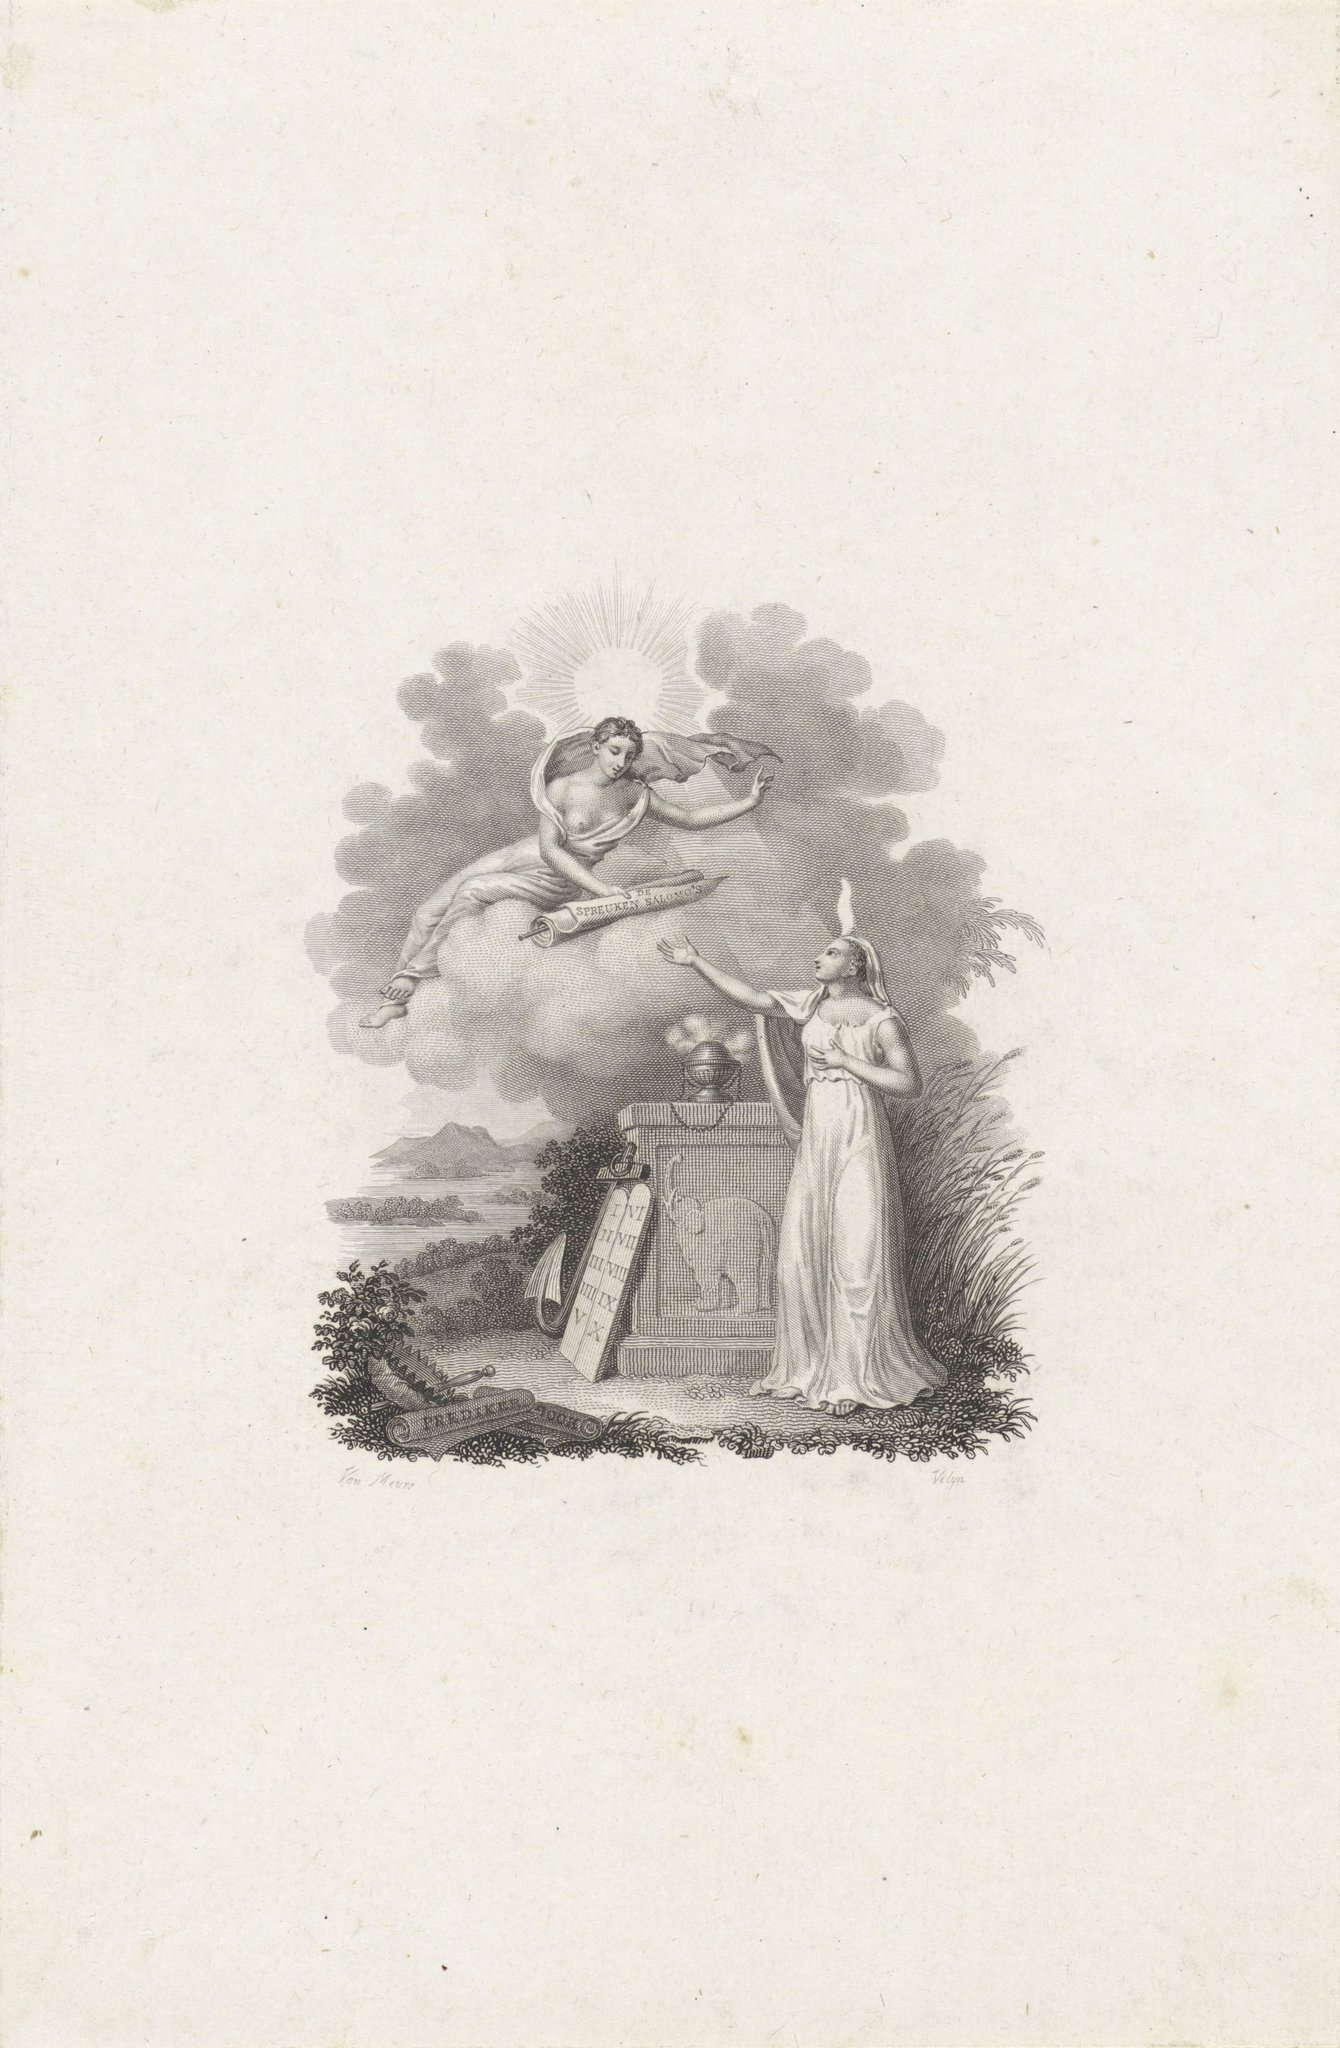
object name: print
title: Vrouw krijgt bijbeltekst aangereikt uit de hemel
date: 1797-1836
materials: paper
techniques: etching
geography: netherlands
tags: censer, pedestal of a piece of sculpture (perhaps in the form of a herm), inspiration; 'ispiratione' (ripa)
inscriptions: collector's mark: Lugt 2228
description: Een allegorische vrouwenfiguur met een vlam op het hoofd, de goddelijke inspiratie, krijgt van een vrouwenfiguur op een wolkendek een rol aangereikt met de tekst: De spreuken van Salomo.. Tussen hen in een sokkel waarop een beeltenis van een olifant, met daarnaast een anker en twee stenen tabletten met de Romeinse cijfers I tot en met X. Op de sokkel een wierookvat.